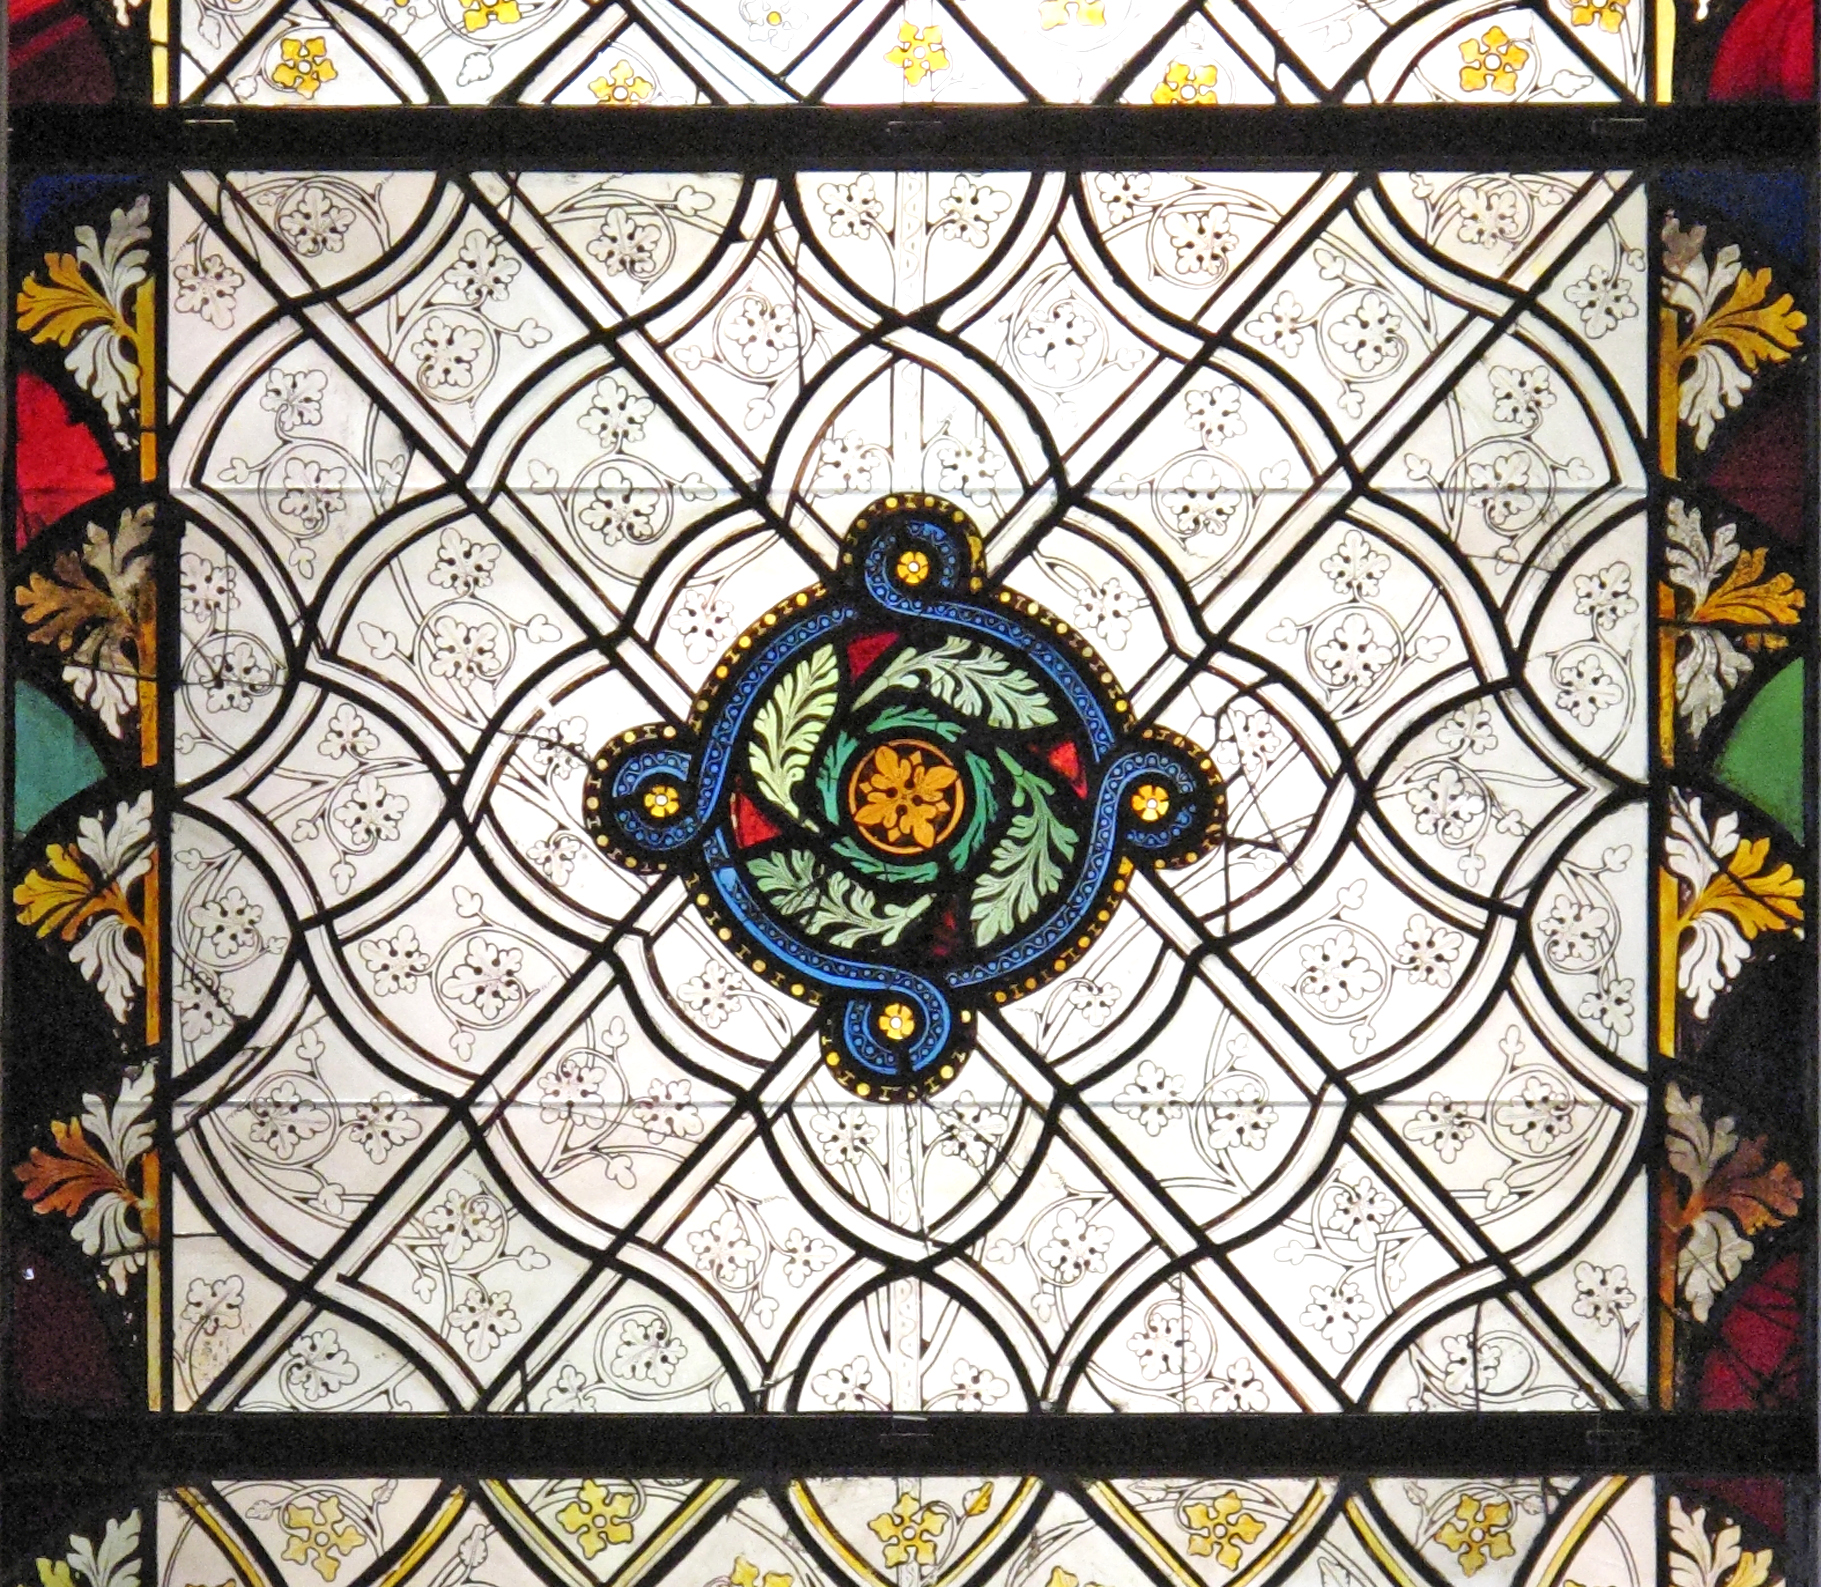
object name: panel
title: Grisaille Panel with Foliate Pattern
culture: french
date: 1320-1330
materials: glass, metal, paint, pigment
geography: france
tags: leaves